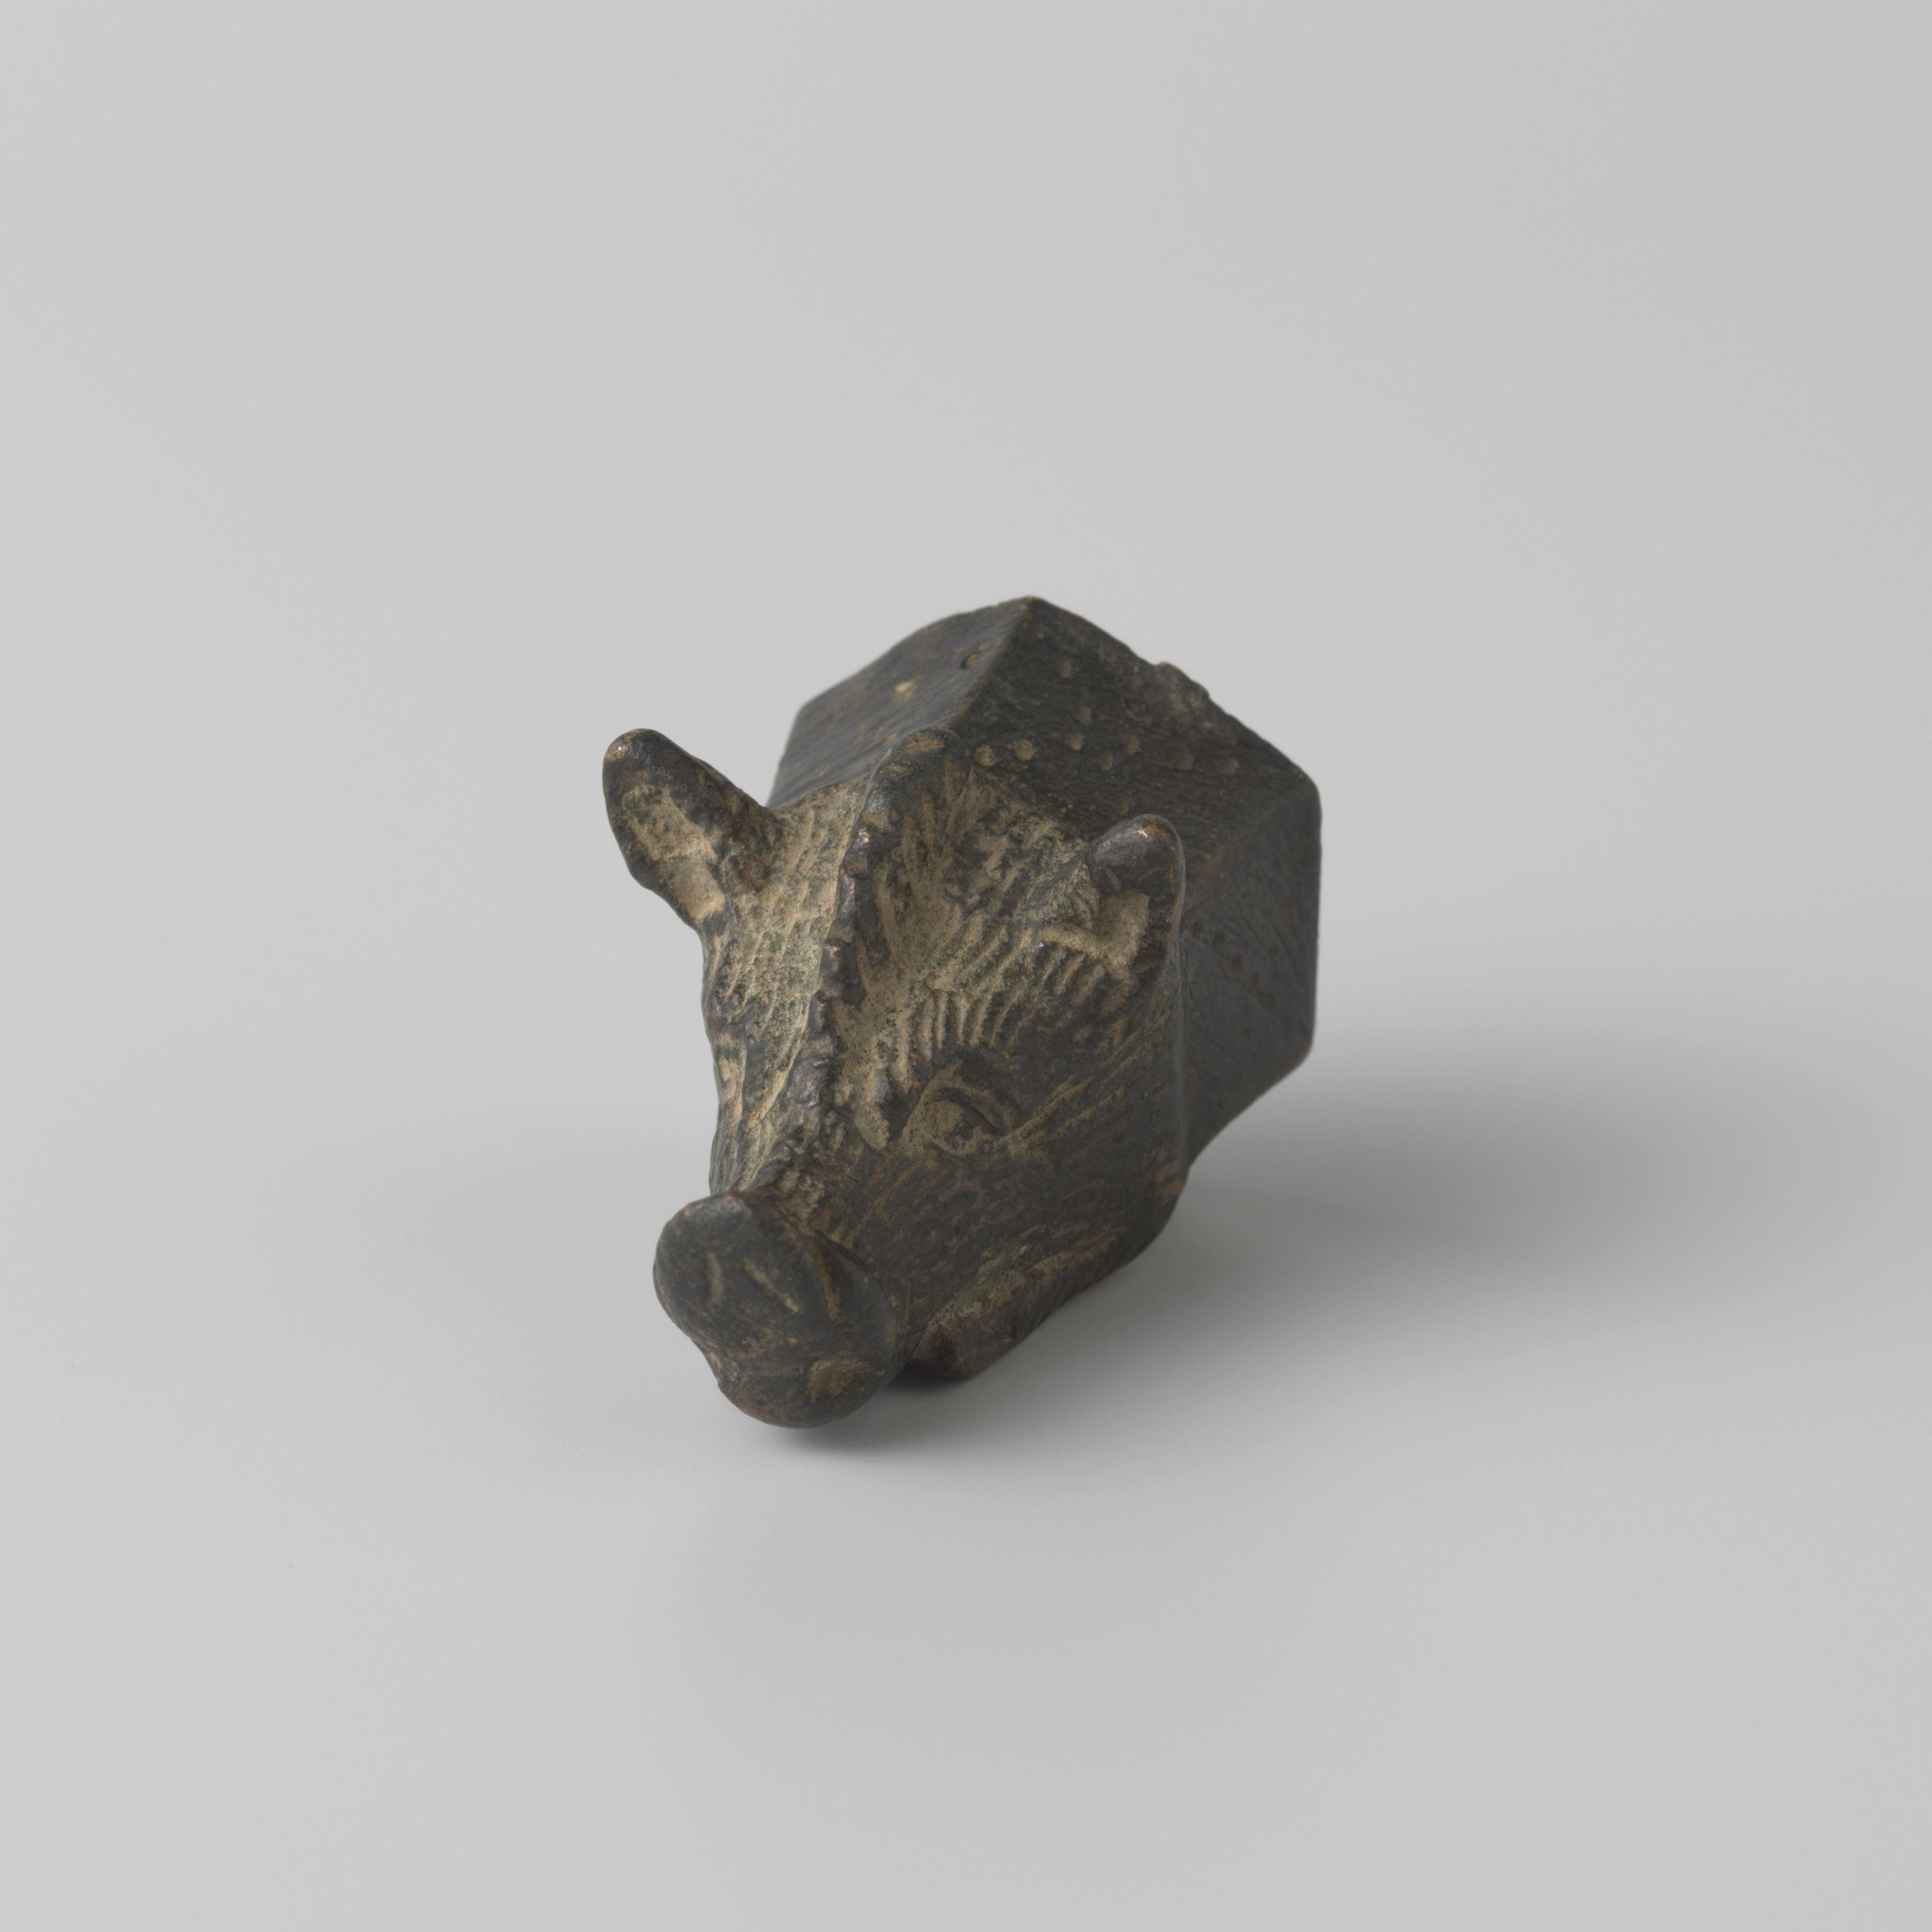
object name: figure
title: Kop van een everzwijn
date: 1400-1600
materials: brass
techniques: casting, metalworking, punching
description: Het gegoten en geciseleerd bewerkte voorwerp heeft de vorm van een zwijnskop met slagtanden en voorpoten. Achter de kop het aanzetstuk met zes vlakken, waarin uit punten samengestelde diagonalen zijn geponst. Binnenin een gietijzeren punt ter bevestiging aan een groter geheel.